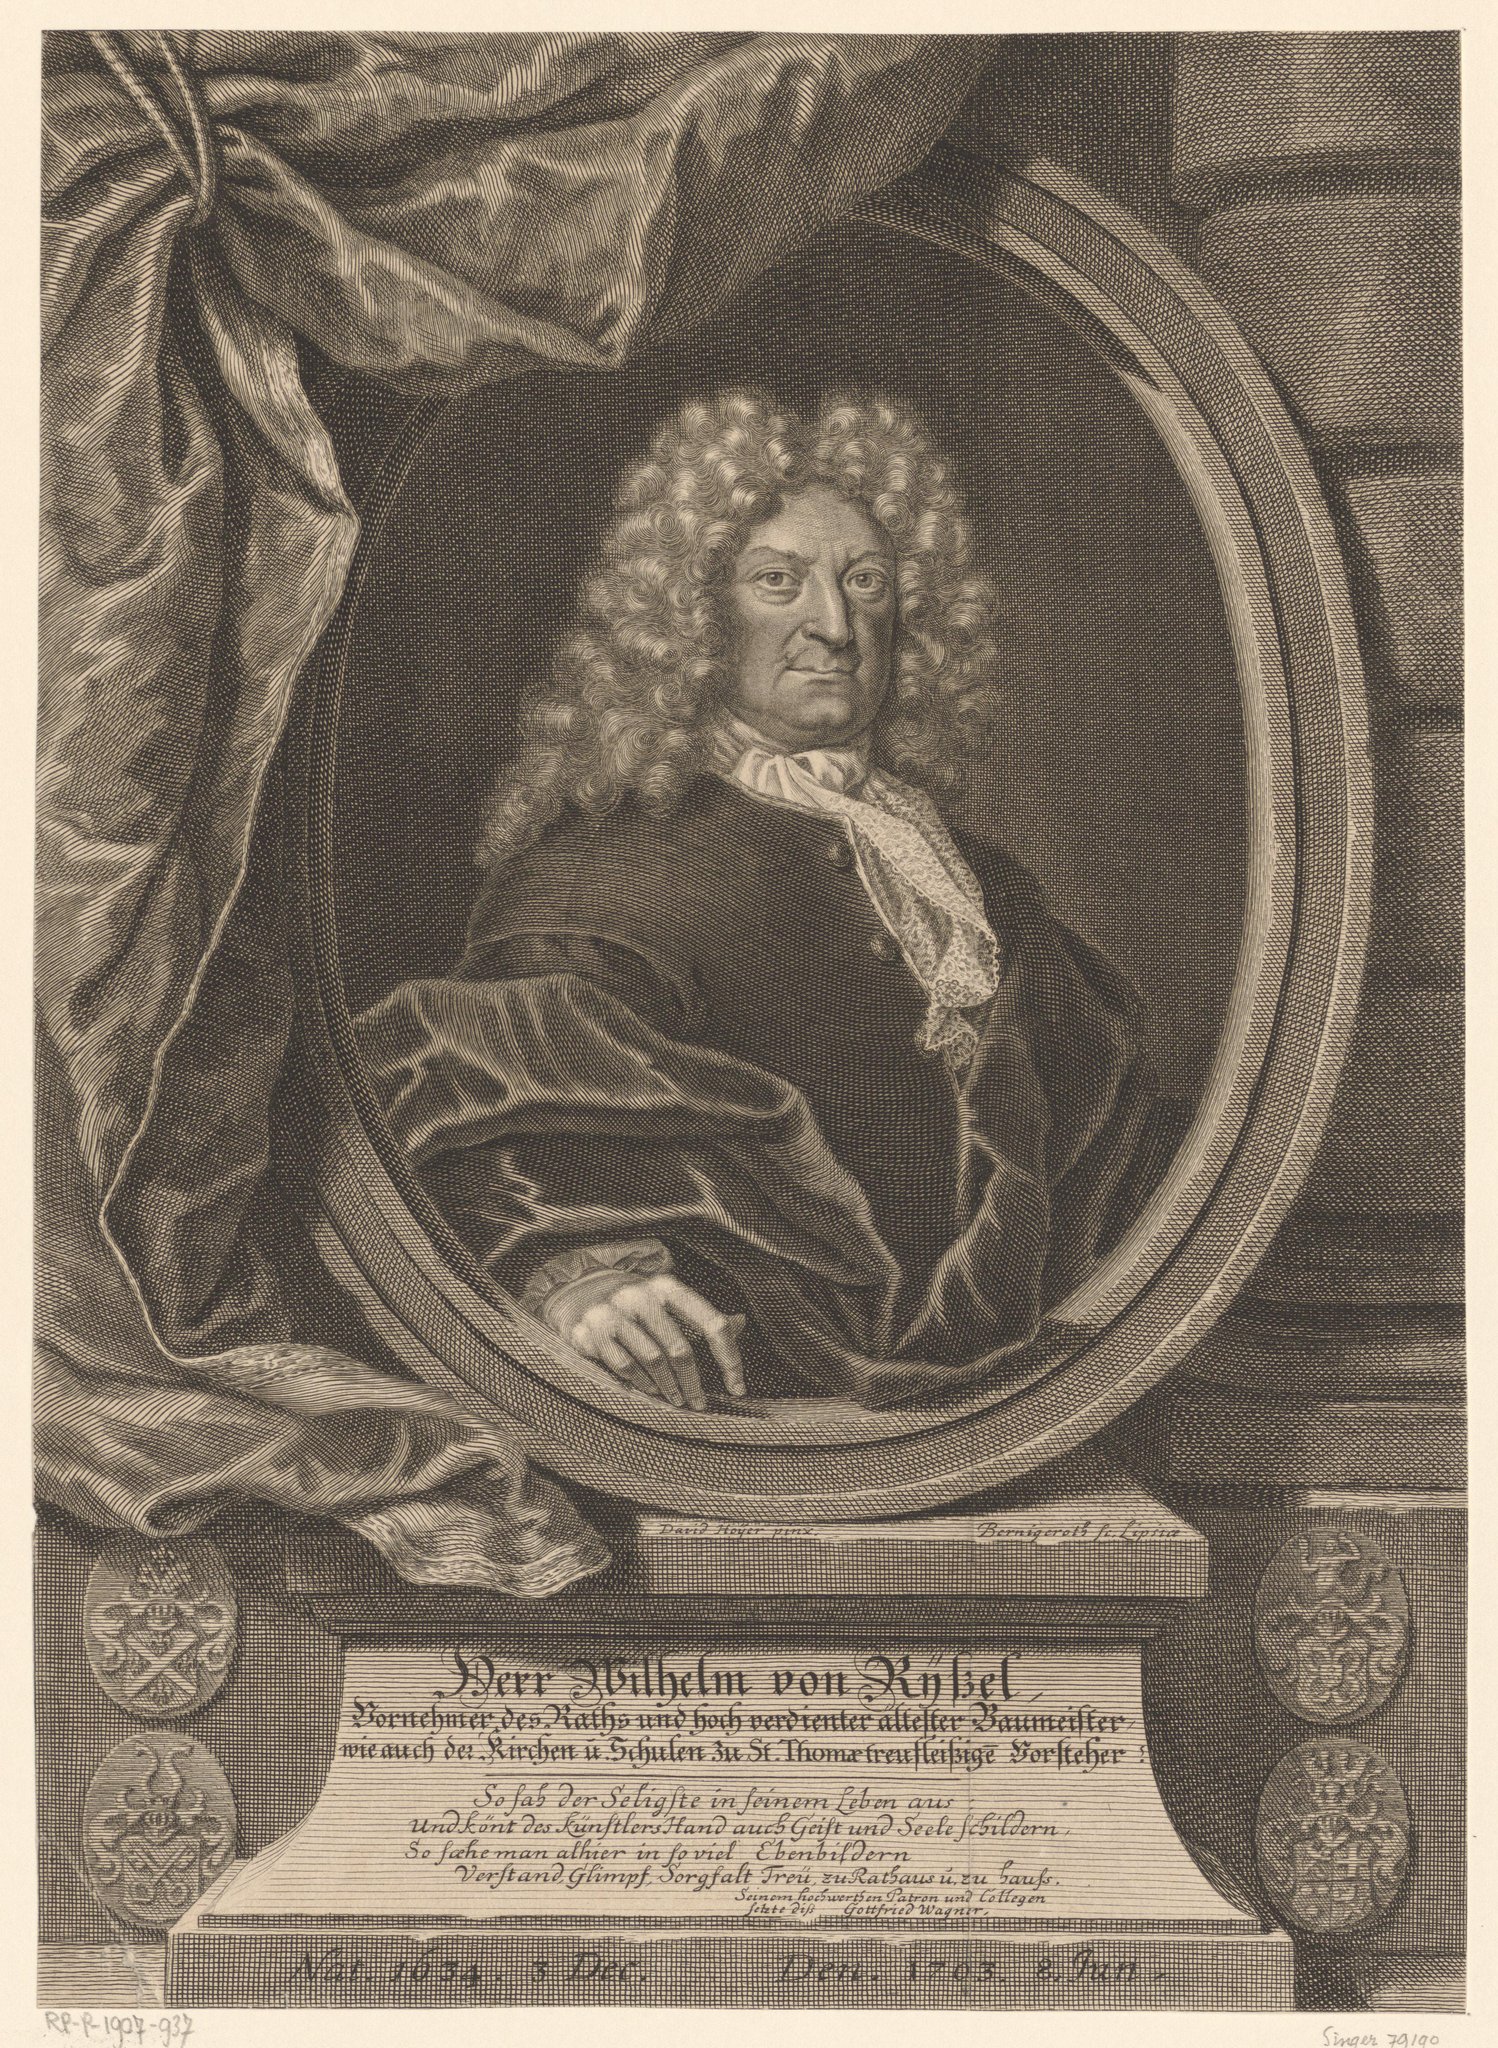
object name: print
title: Portret van Wilhelm von Ryssel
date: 1703-1733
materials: paper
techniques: engraving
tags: historical persons, armorial bearing, heraldry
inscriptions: collector's mark: Lugt 2228, : Lugt 358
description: Onder het portret een vierregelig vers en vier wapenschilden.